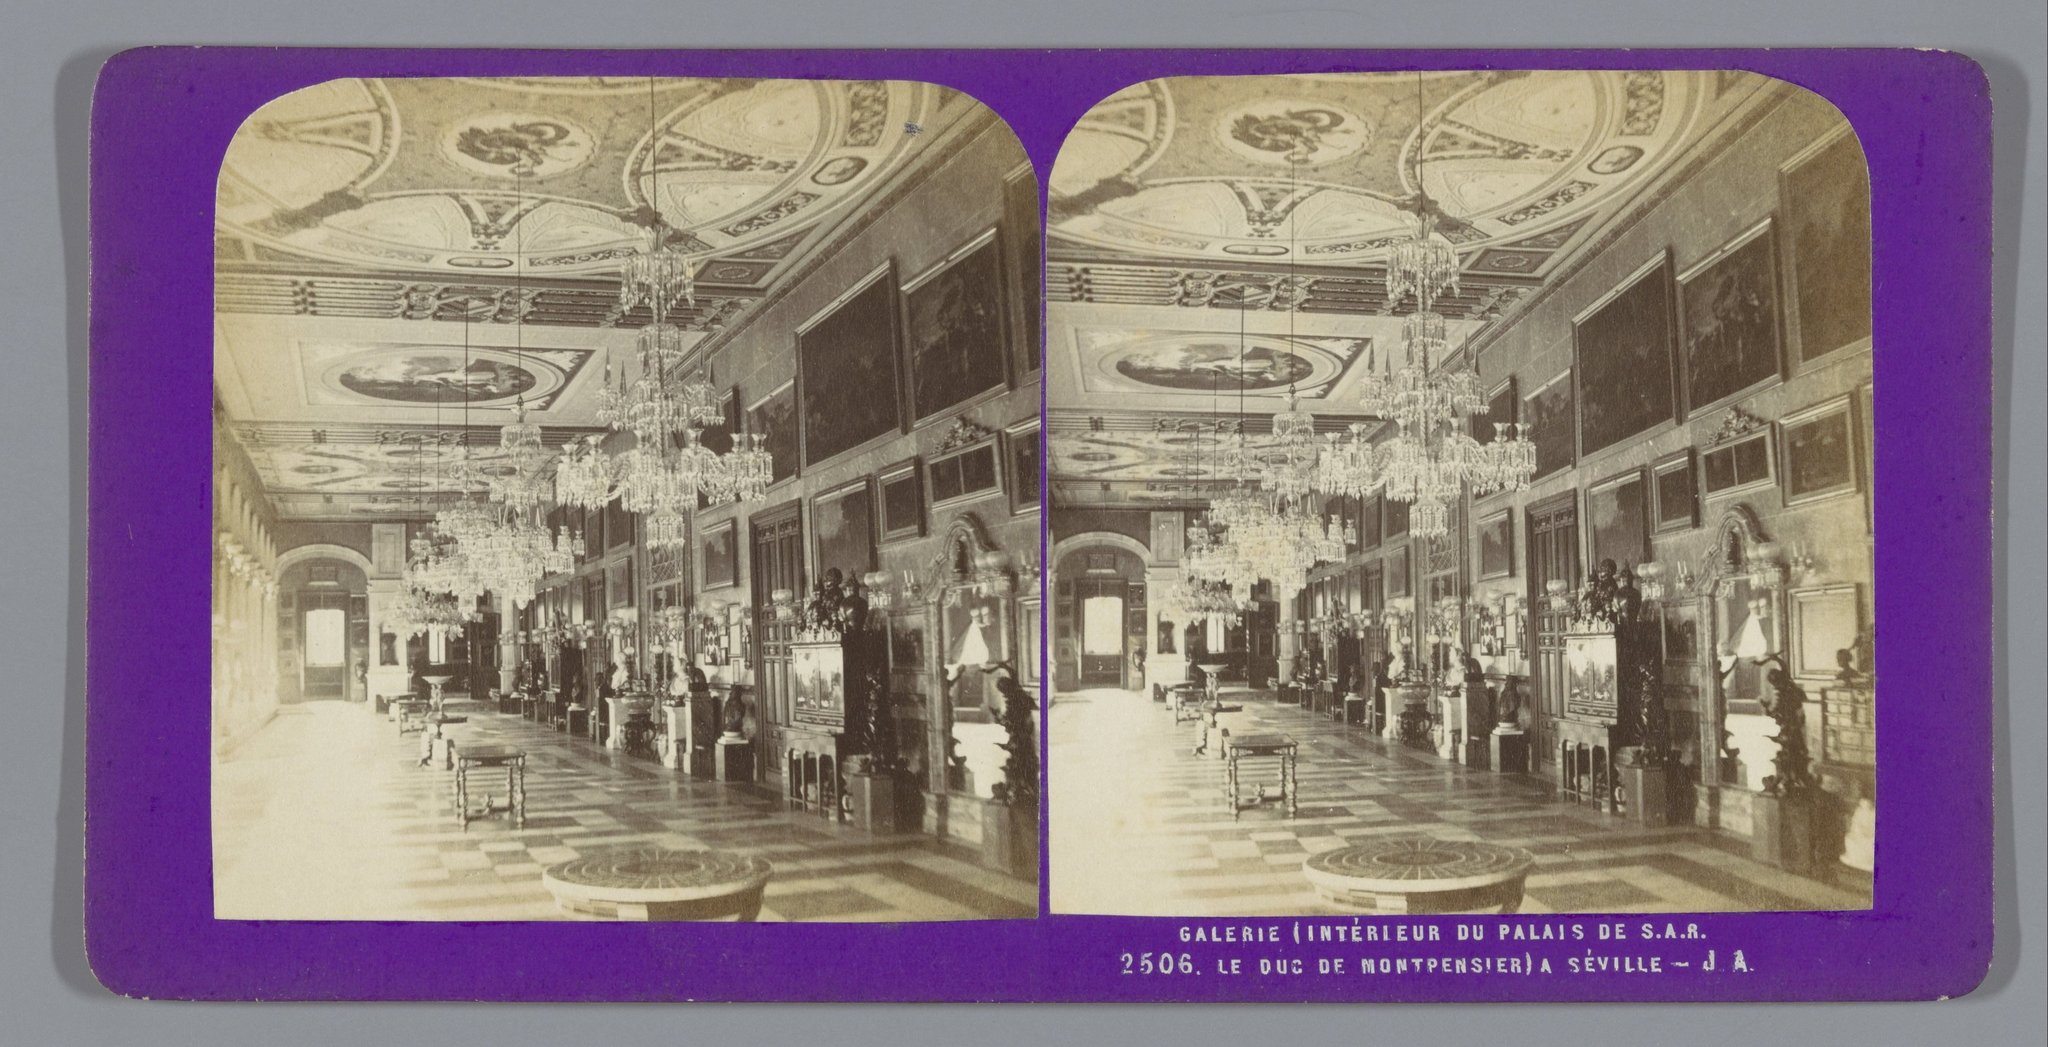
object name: stereograph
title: Interieur van een galerij van het Palacio de San Telmo in Sevilla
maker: jean andrieu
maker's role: fotograaf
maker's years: 1816-1872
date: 1862-1876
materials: cardboard, photographic support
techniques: albumen print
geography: palacio de san telmo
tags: chandelier, candelabrum, palace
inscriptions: number: ‘2506.’